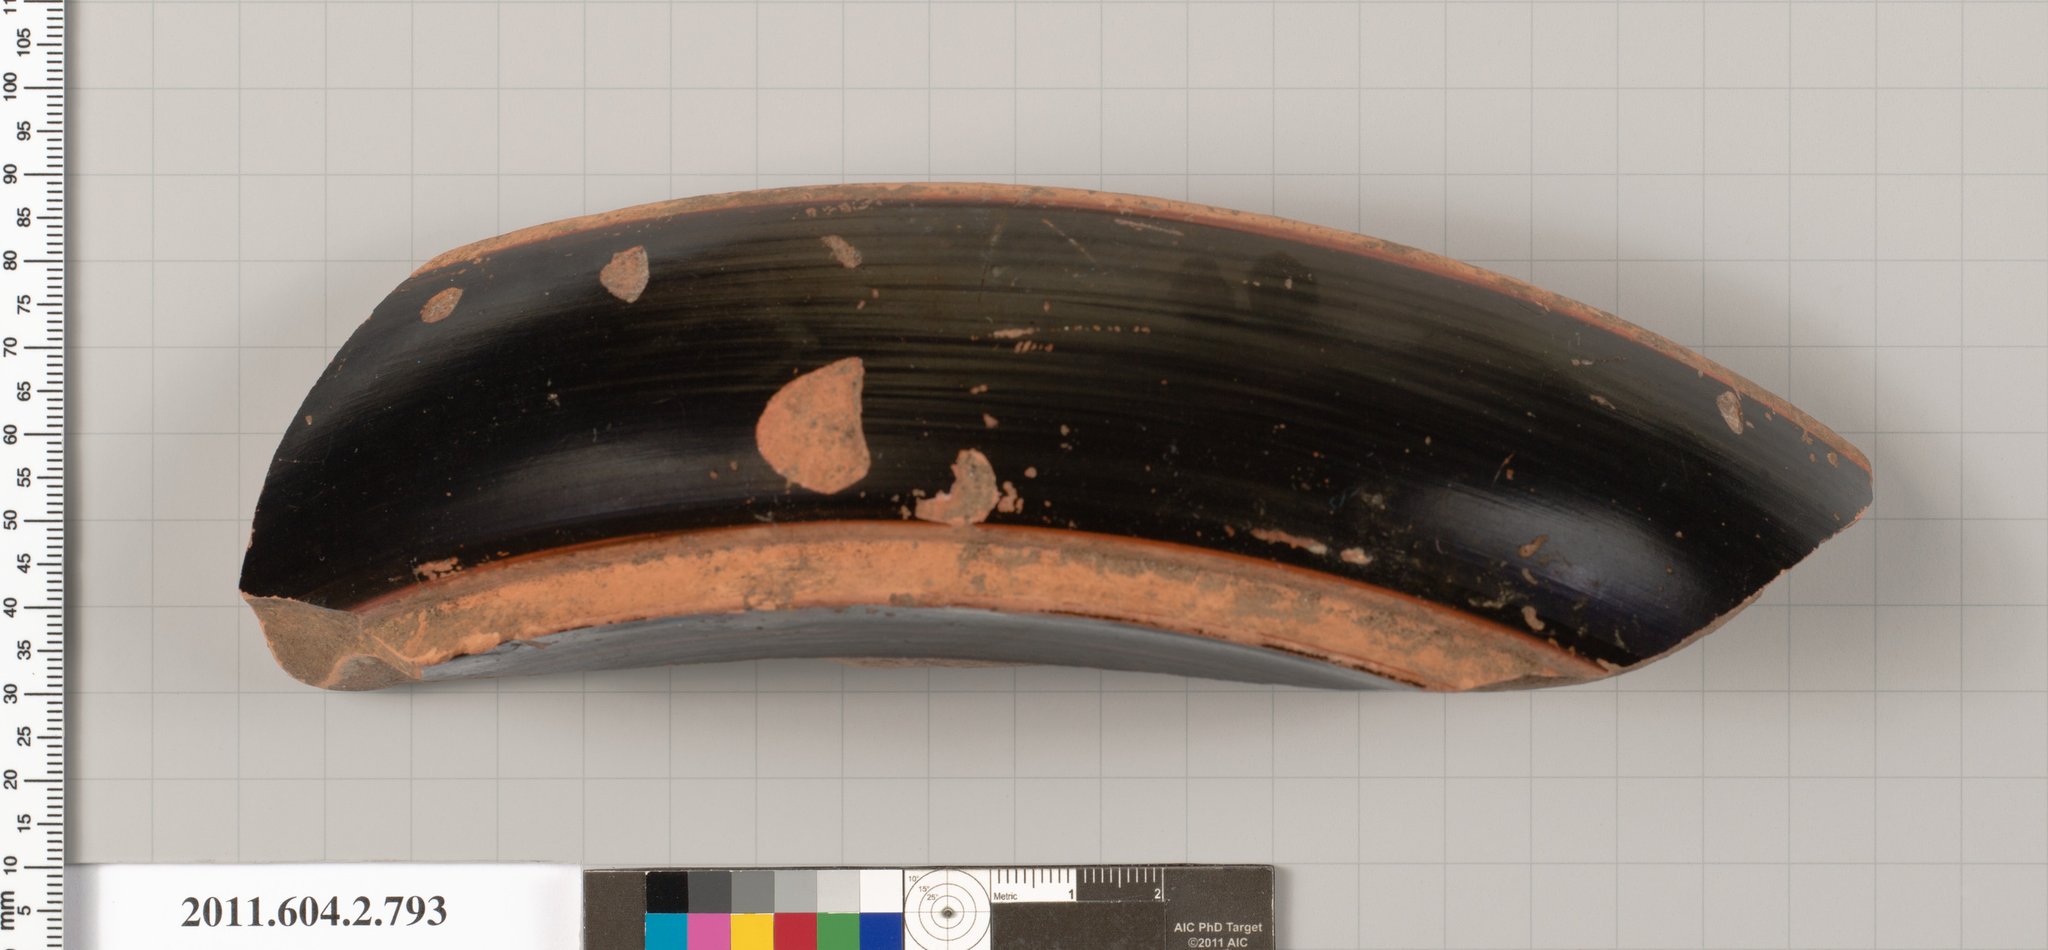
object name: calyx krater fragment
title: Terracotta fragment of a calyx-krater (bowl for mixing wine and water)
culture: greek, attic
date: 600-401 BCE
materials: terracotta